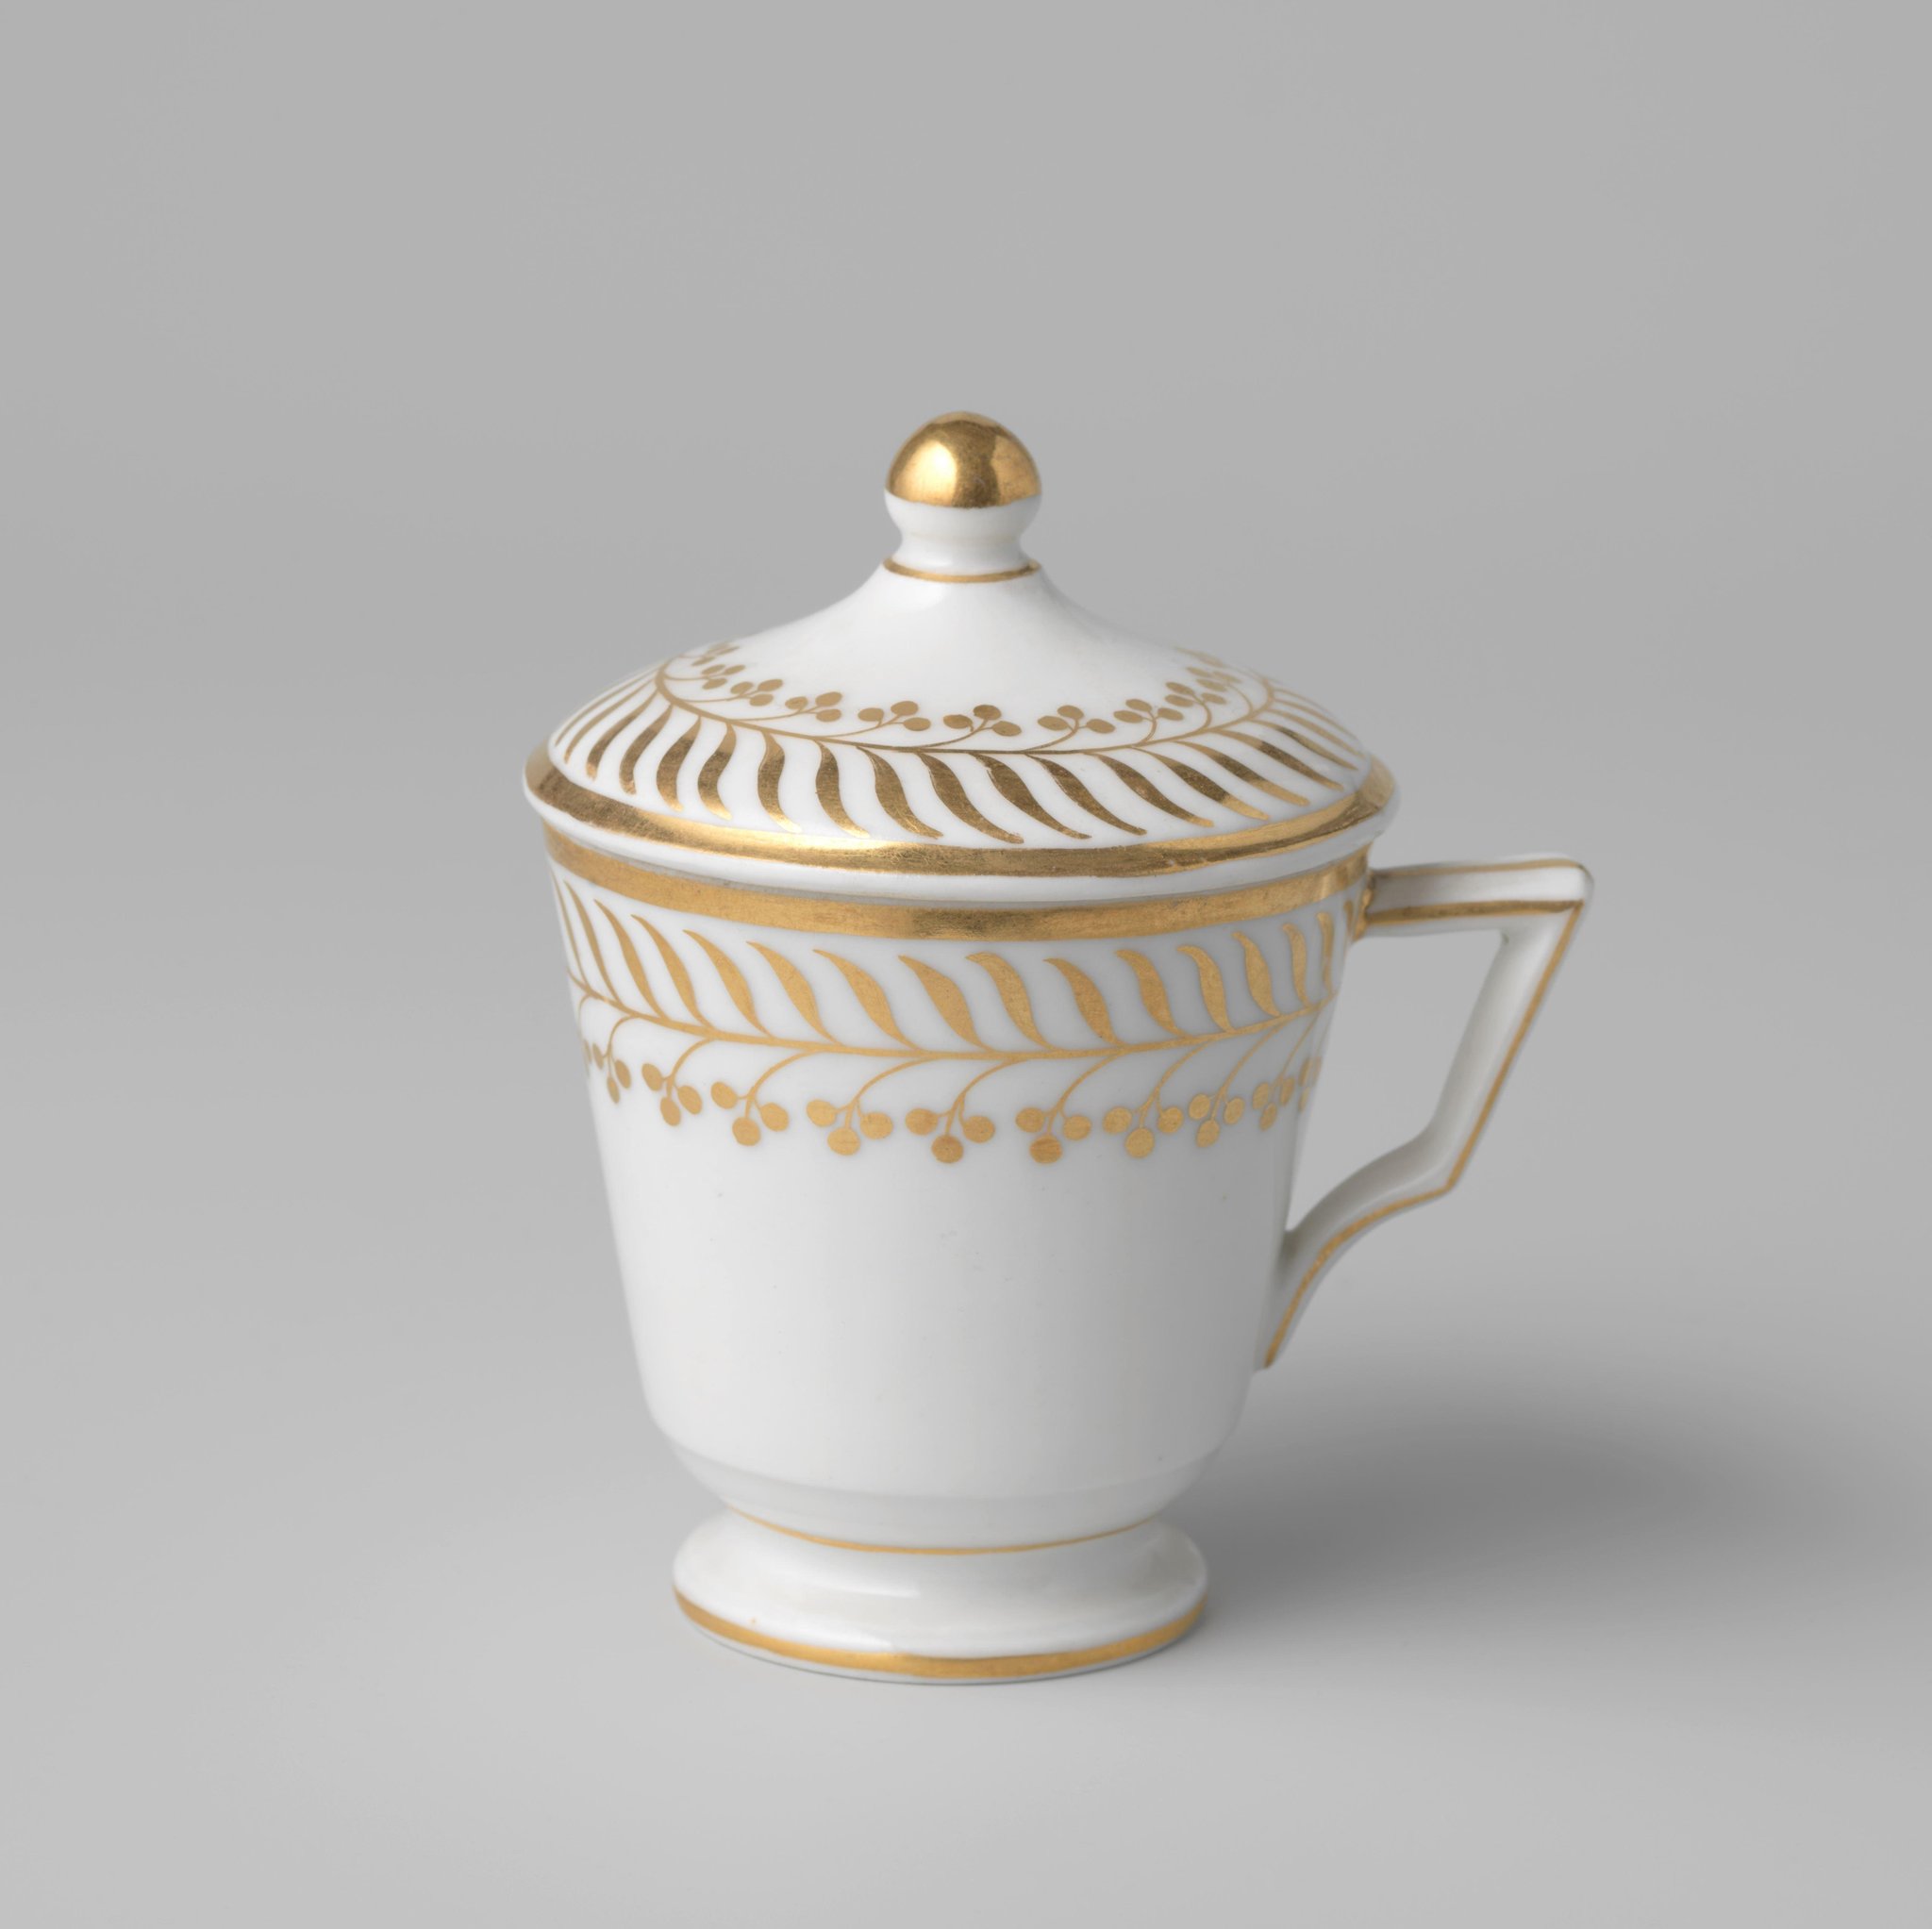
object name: lid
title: Cover of a cup (pot de crème) with stylized floral scrolls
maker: Anonymous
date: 1800-1810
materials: glaze, gold, paint, porcelain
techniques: firing, forming, gilding, vitrification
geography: france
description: Deksel van porselein waarop een vergulde knop. Versierd met gouden biezen en langs de randen beschilderd met een doorlopende tak met aan de ene zijde bladeren, aan de andere zijde steeds een tak met drie vruchten.